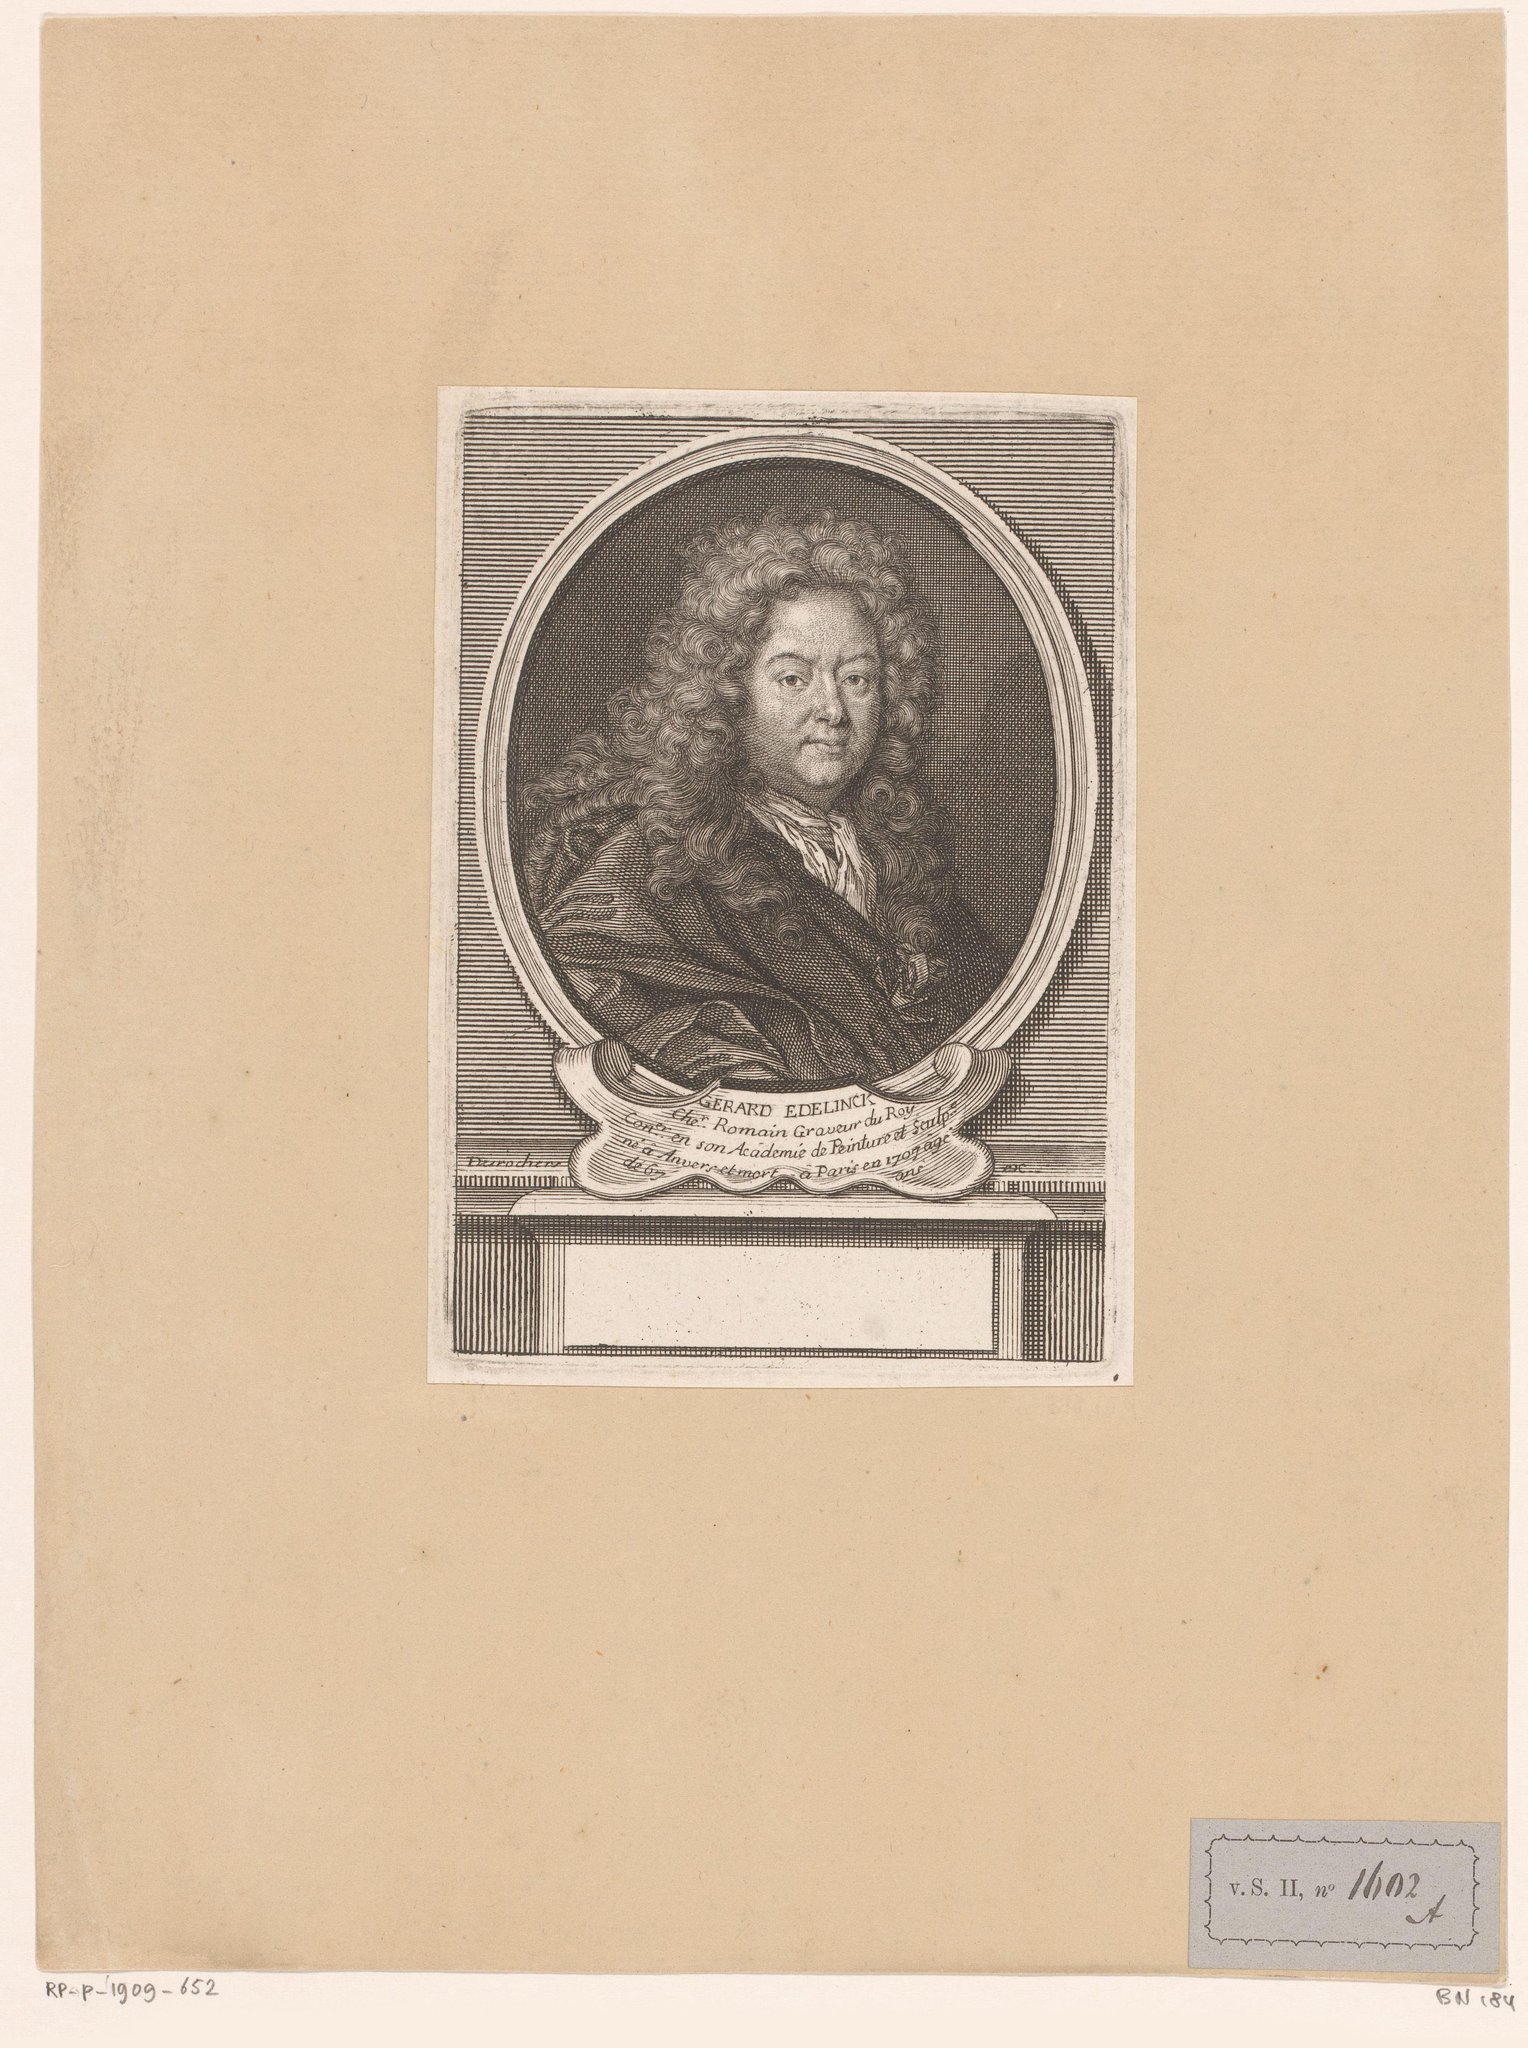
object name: print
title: Verzameling portretten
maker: étienne desrochers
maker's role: print maker, publisher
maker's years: 1668-1741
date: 1726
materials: paper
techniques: engraving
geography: paris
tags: gerard edelinck, historical persons, portrait, self-portrait of graphic artist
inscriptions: collector's mark: Lugt 2228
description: Behoort waarschijnlijk tot een serie portretten, grotendeels door Etienne Desrochers, getiteld: 'Recueil de portraits de personnes qui se sont distinguées tant dans les Armes que dans Belles-Lettres et les Arts, comme aussi la famille royale de France et autres cours étrangères'. De serie werd initieel uitgegeven door Desrochers en aangekondigd in 'Mercure' in mei 1726, p. 985. Echter was Desrochers reeds enkele jaren eerder begonnen met het uitgeven van de serie. Na de dood van Desrochers werd de serie voortgezet door Gilles Edme Petit. Een latere staat werd uitgegeven door Jean François Daumont in Parijs.